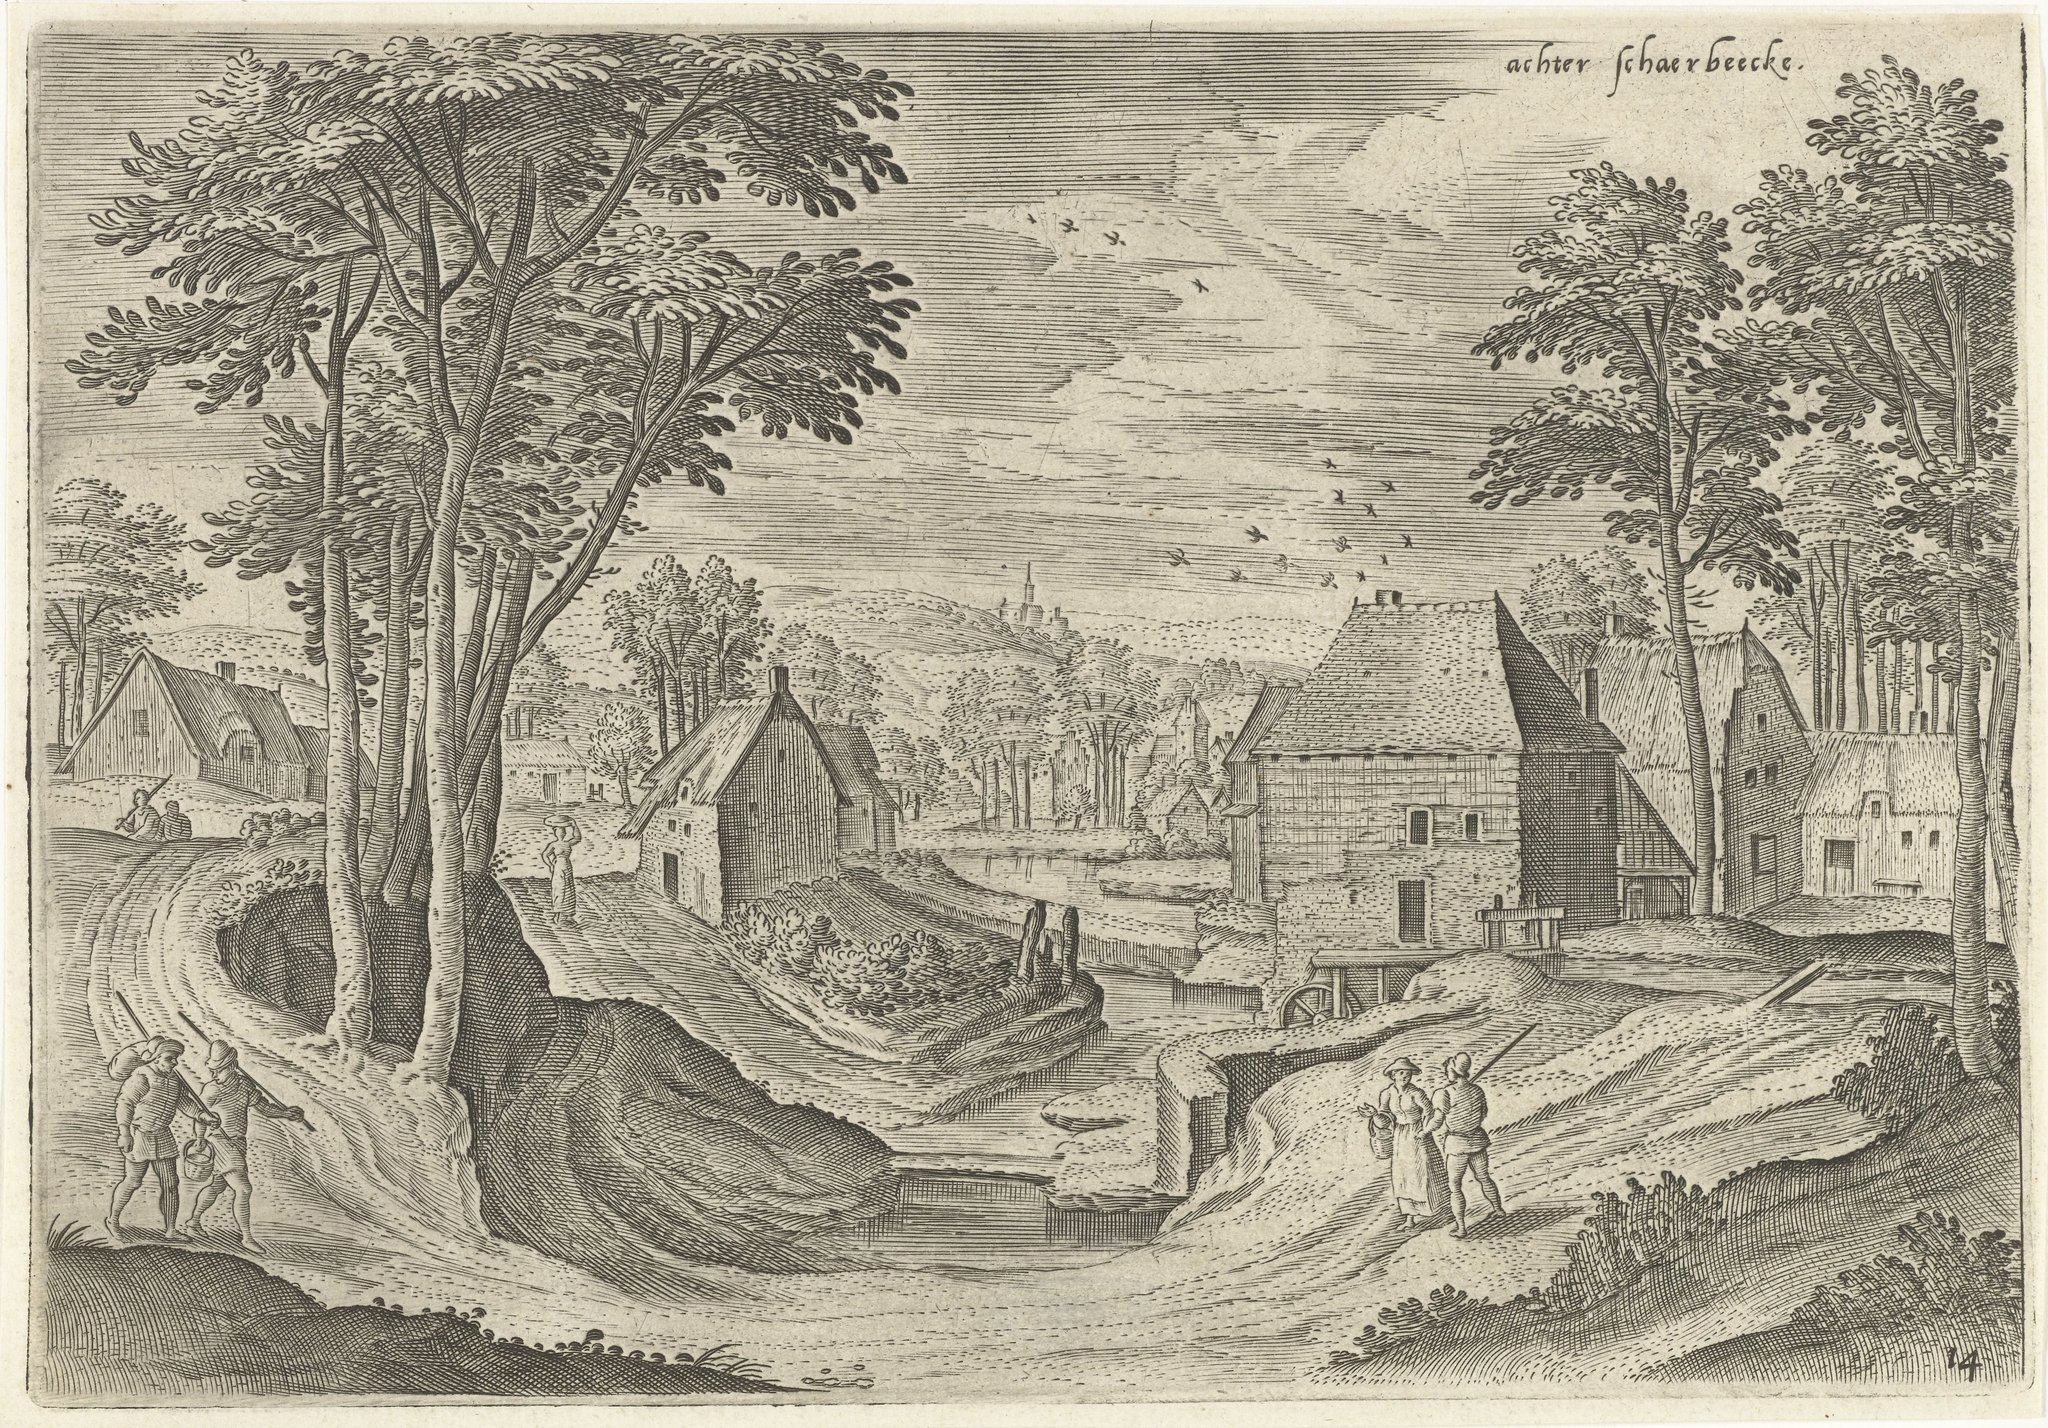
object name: print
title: Gezichten uit de omgeving van Brussel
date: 1530-1580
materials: paper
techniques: engraving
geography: antwerp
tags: village (+ city(-scape) with figures, staffage)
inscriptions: collector's mark: Lugt 2228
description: Gezicht op de omgeving van Schaarbeek, vlakbij Brussel. De prent is deel van een serie met gezichten uit de omgeving van Brussel.